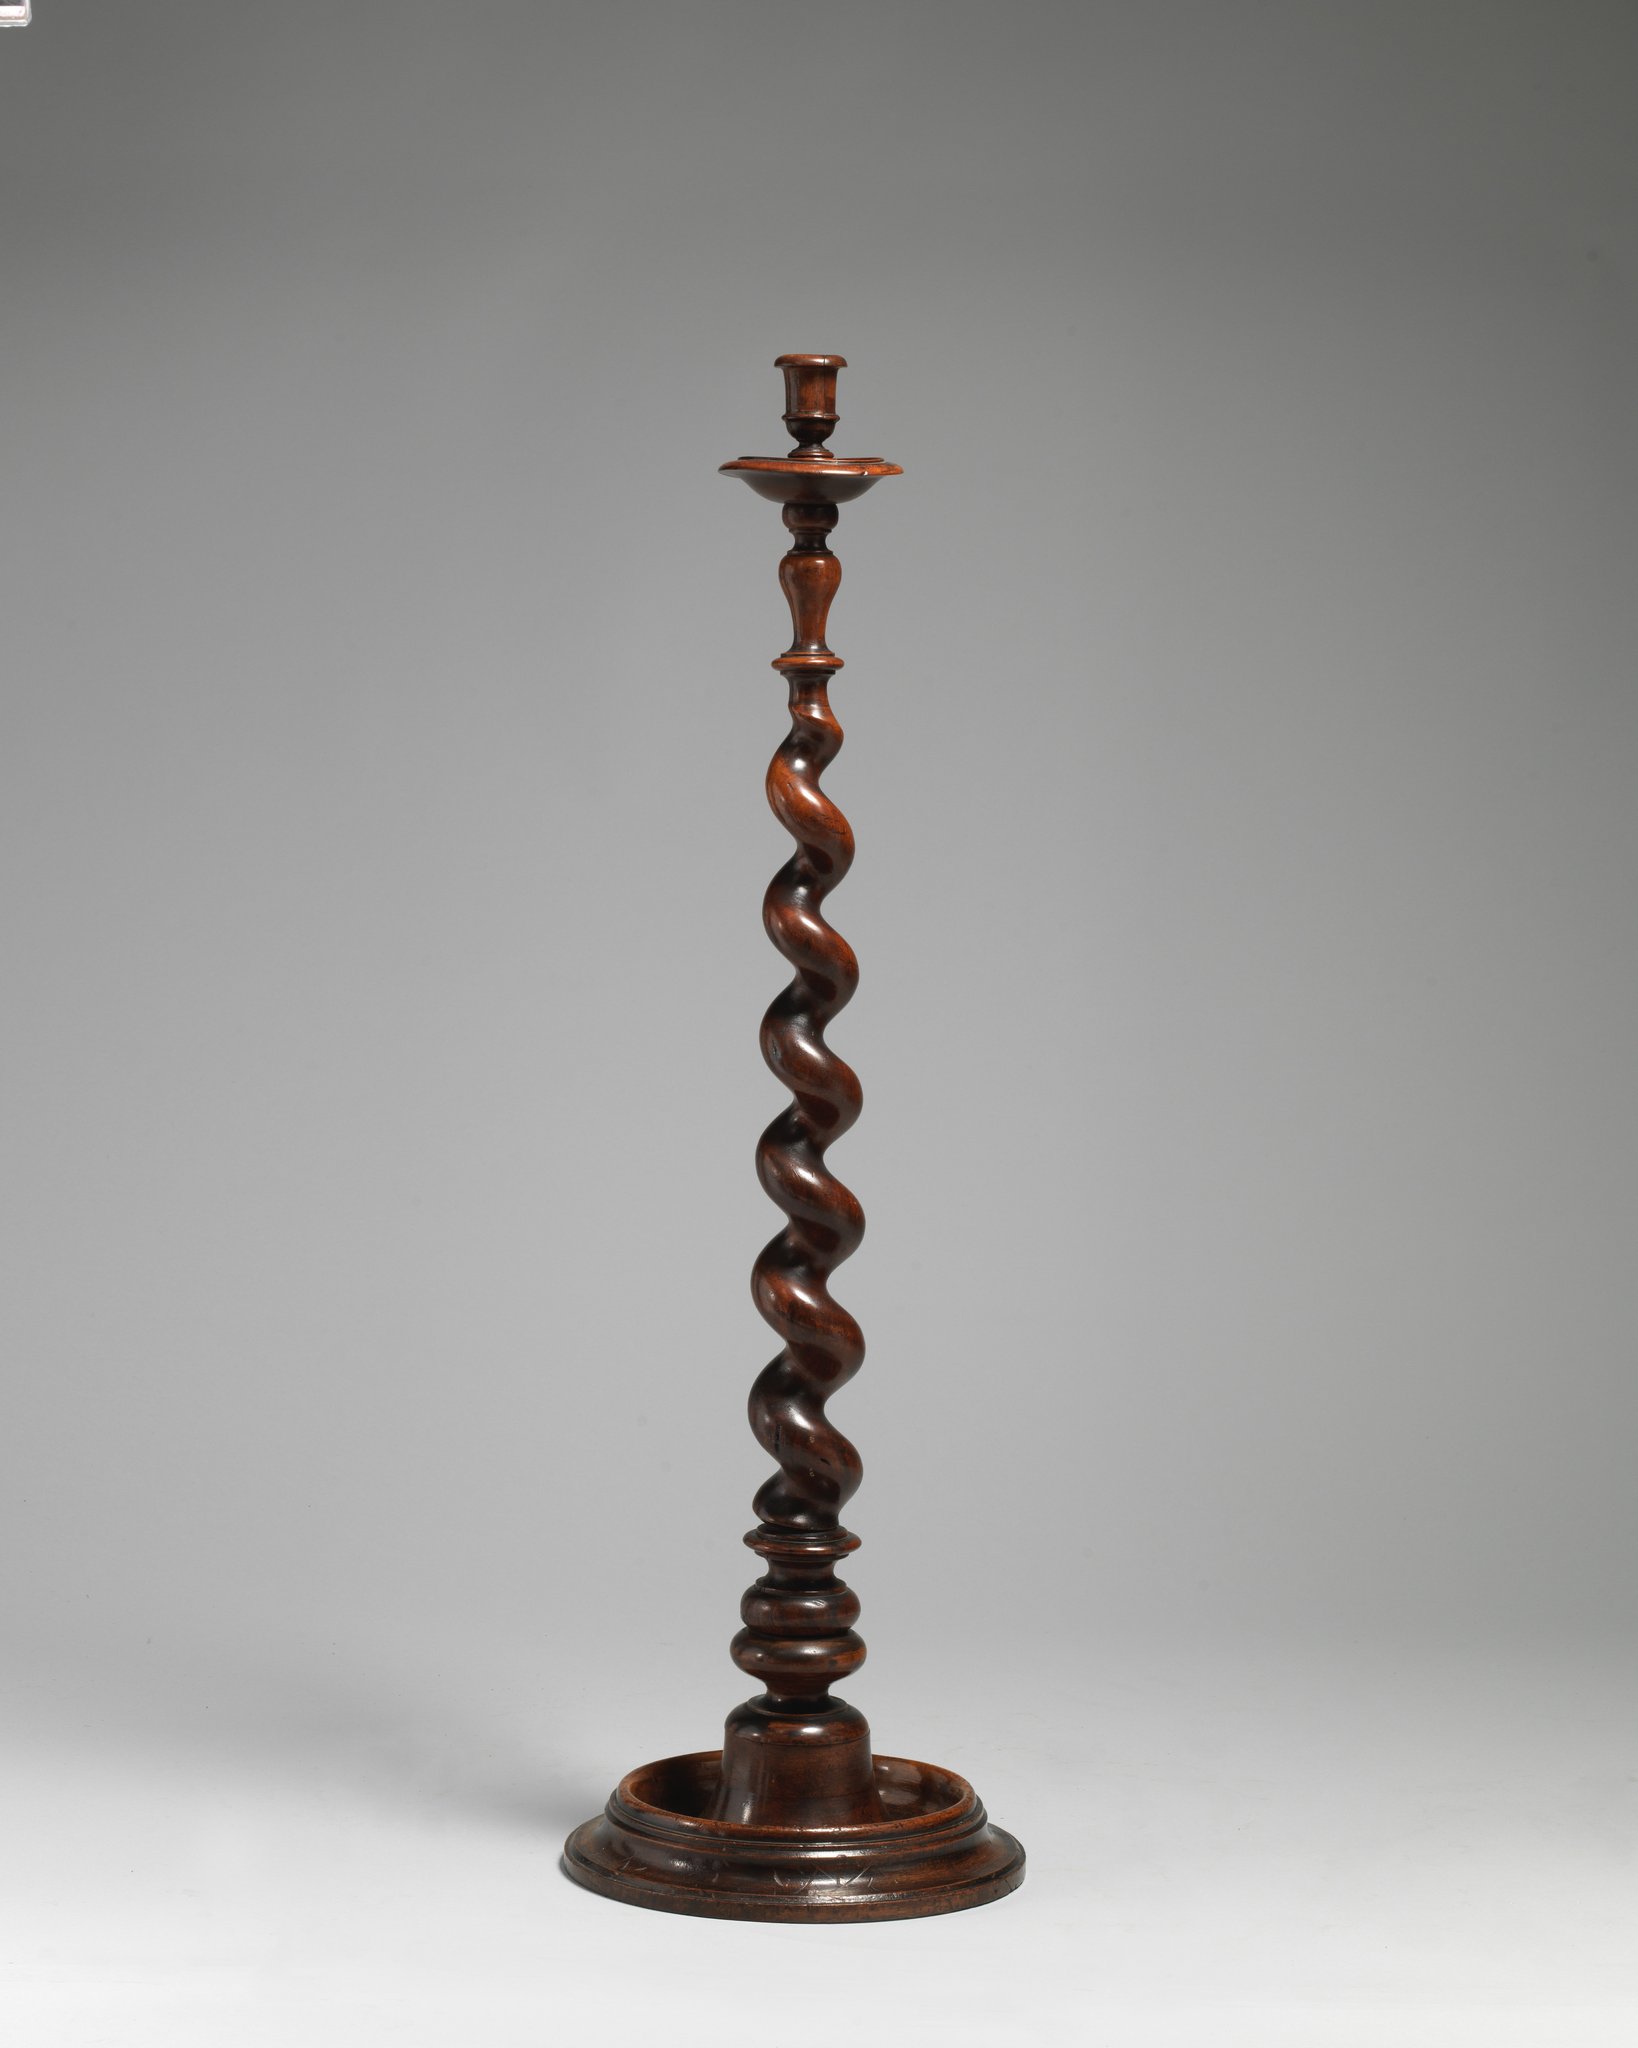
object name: candlestand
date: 1710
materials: wood